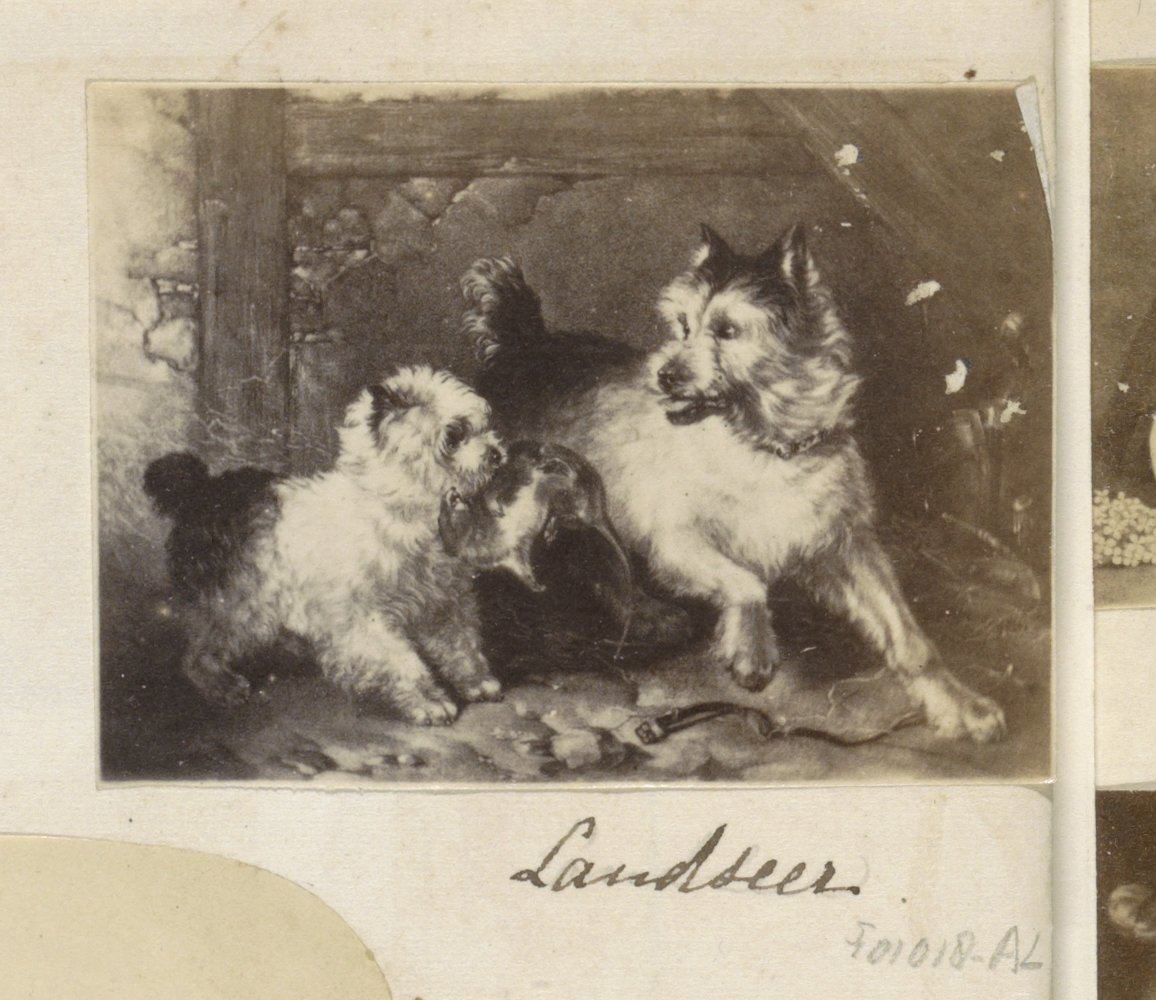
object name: photograph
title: Fotoreproductie van een schilderij van Edwin Henry Landseer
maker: Anonymous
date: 1860-1870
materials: paper, photographic support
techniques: albumen print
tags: dog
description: Onderdeel van Engels familiealbum met foto's van personen, reizen, cricket en kunstwerken.